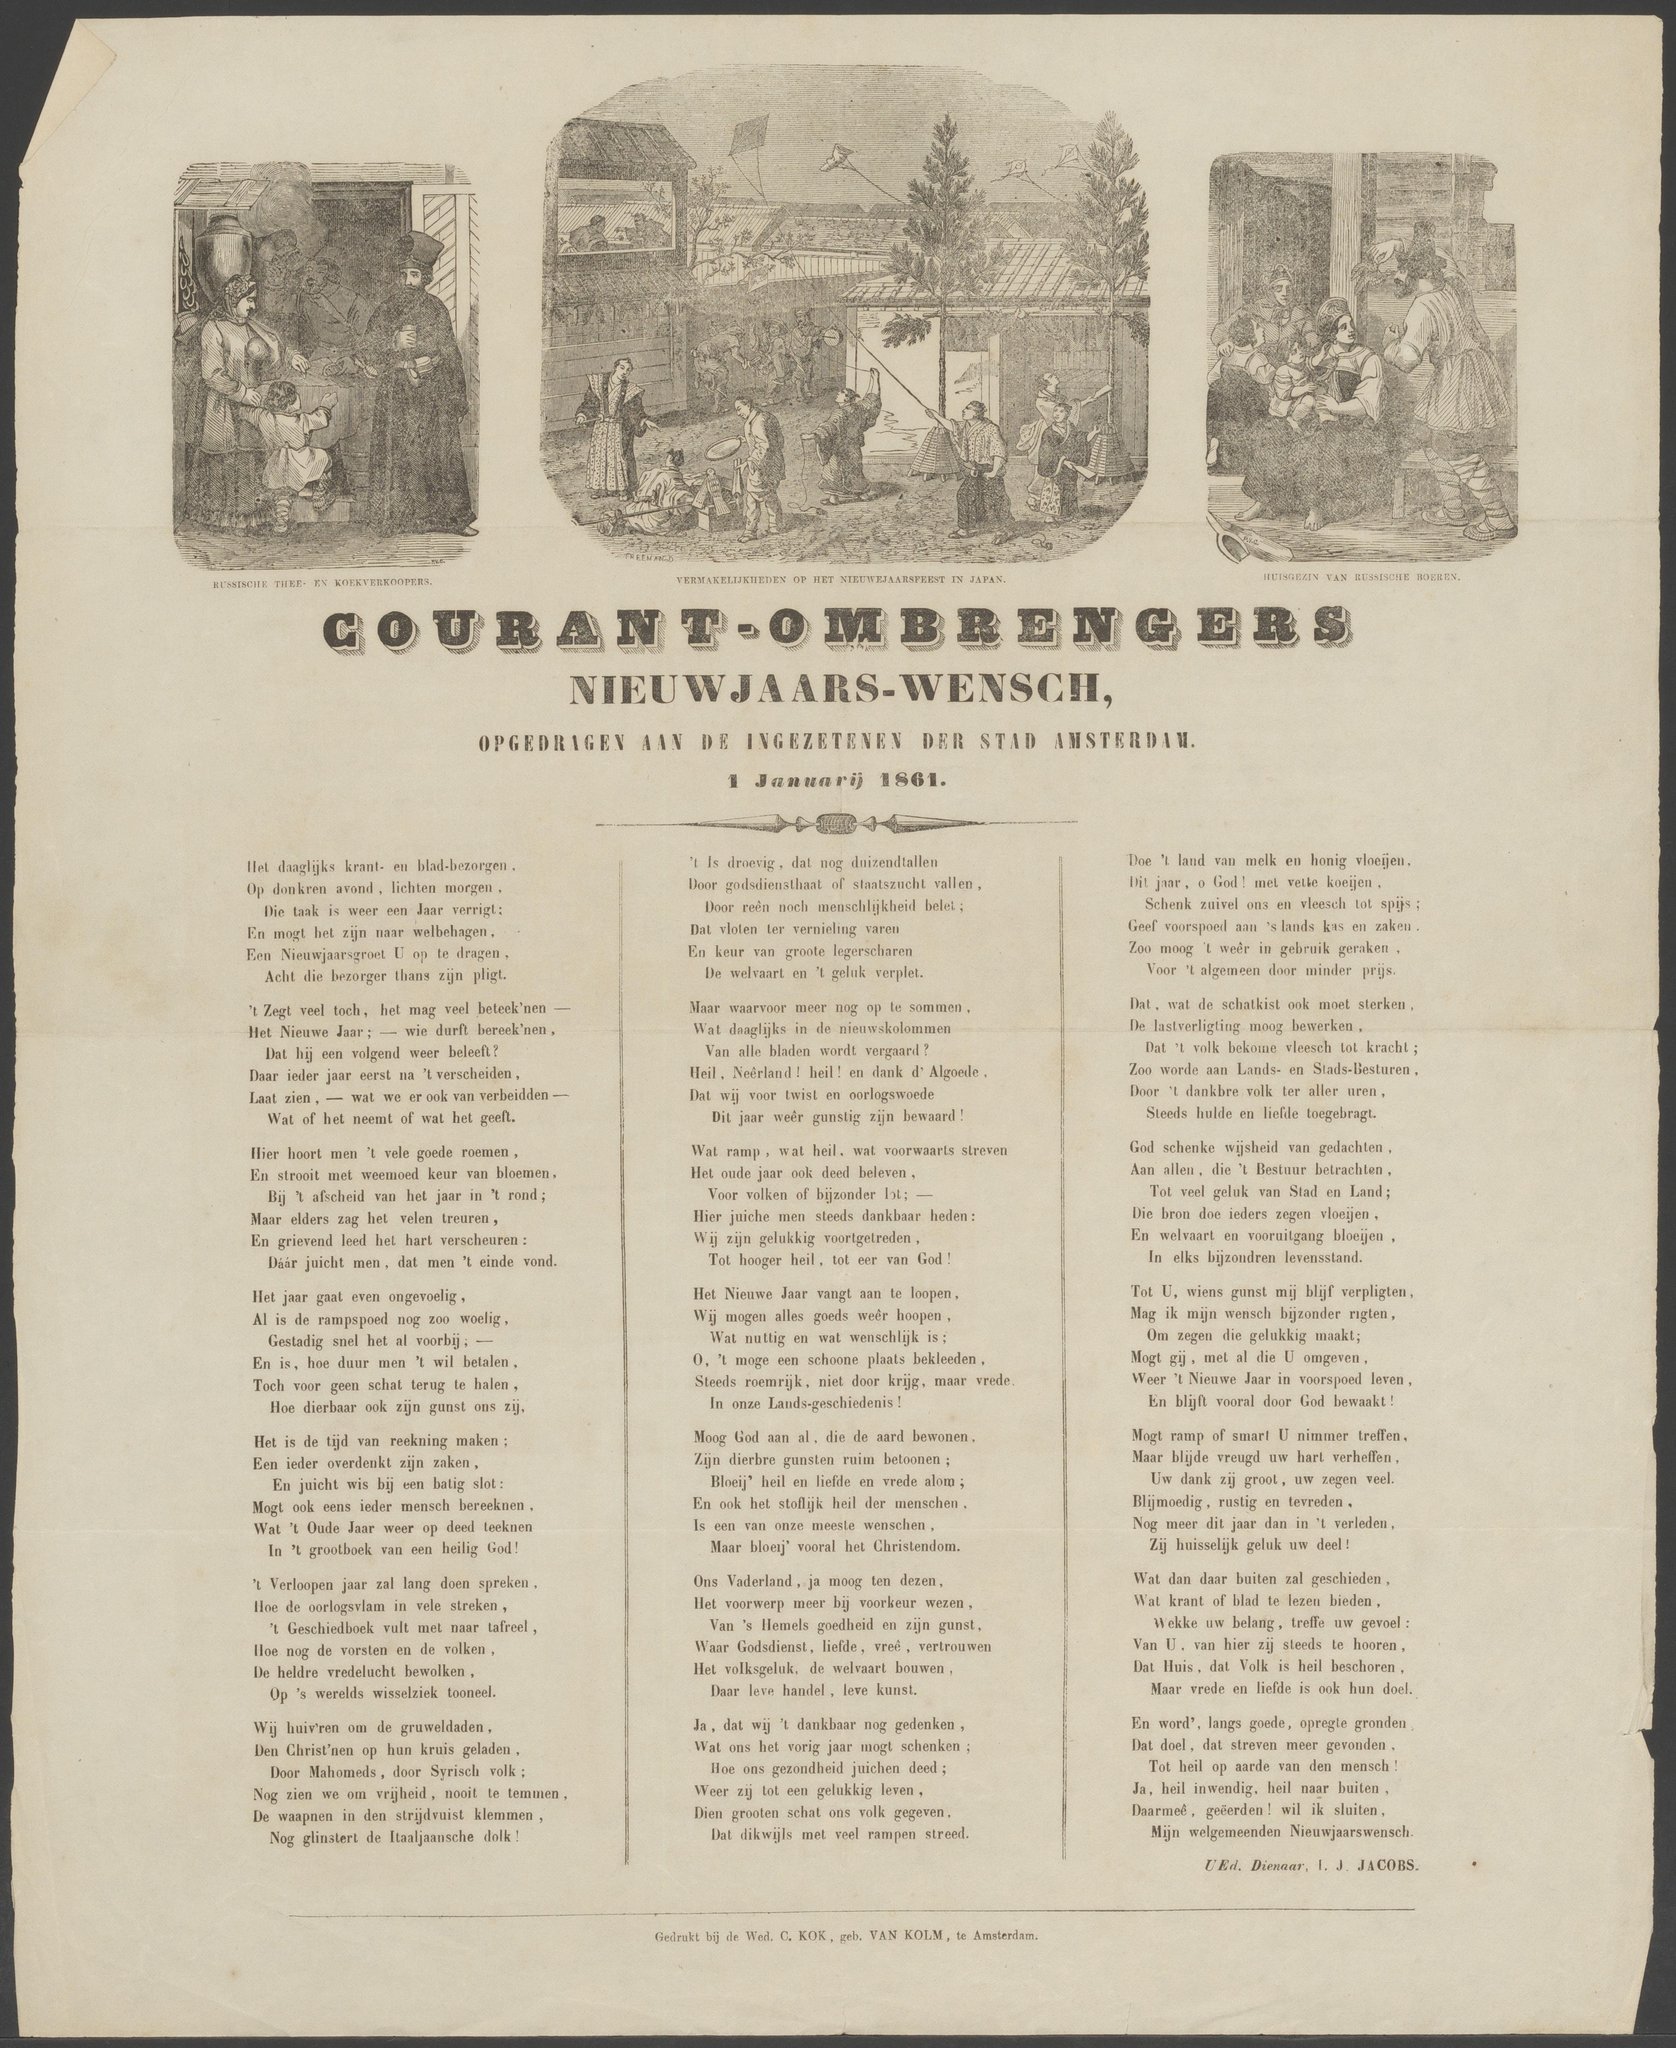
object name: print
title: Courant-ombrengers Nieuwjaars-wensch, opgedragen aan de ingezetenen der stad Amsterdam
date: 1860-1861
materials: paper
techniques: letterpress printing, engraving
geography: amsterdam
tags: january 1 (~ festivities), tea-pot; samovar, (flying a) kite, russia, japan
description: Nieuwjaarswens namens de ombrengers van couranten (krantenbezorgers) te Amsterdam, 1861. Bovenaan drie vignetten aan boeken ontleend, met centraal een nieuwjaarsfeest in Japan, links Russische thee- en koffieverkopers, rechts een Russische boerenfamilie. Onderaan een gedicht in drie kolommen. Van de courantombrenger: I.J. Jacobs. Onderwerpsrubrieken binnen de Atlas Zeden en Gewoonten: Zeden en gewoonten in engeren zin, Volksleven, Volksbladen, Nieuwjaars- en Kerstwenschen, Amsterdam.